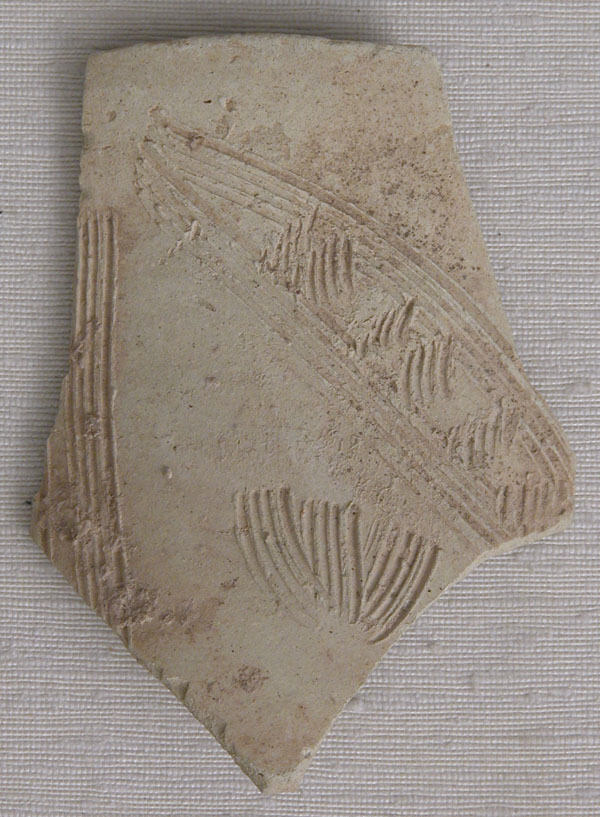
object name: fragment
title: Ceramic Fragment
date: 701-900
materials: earthenware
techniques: incising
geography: iraq